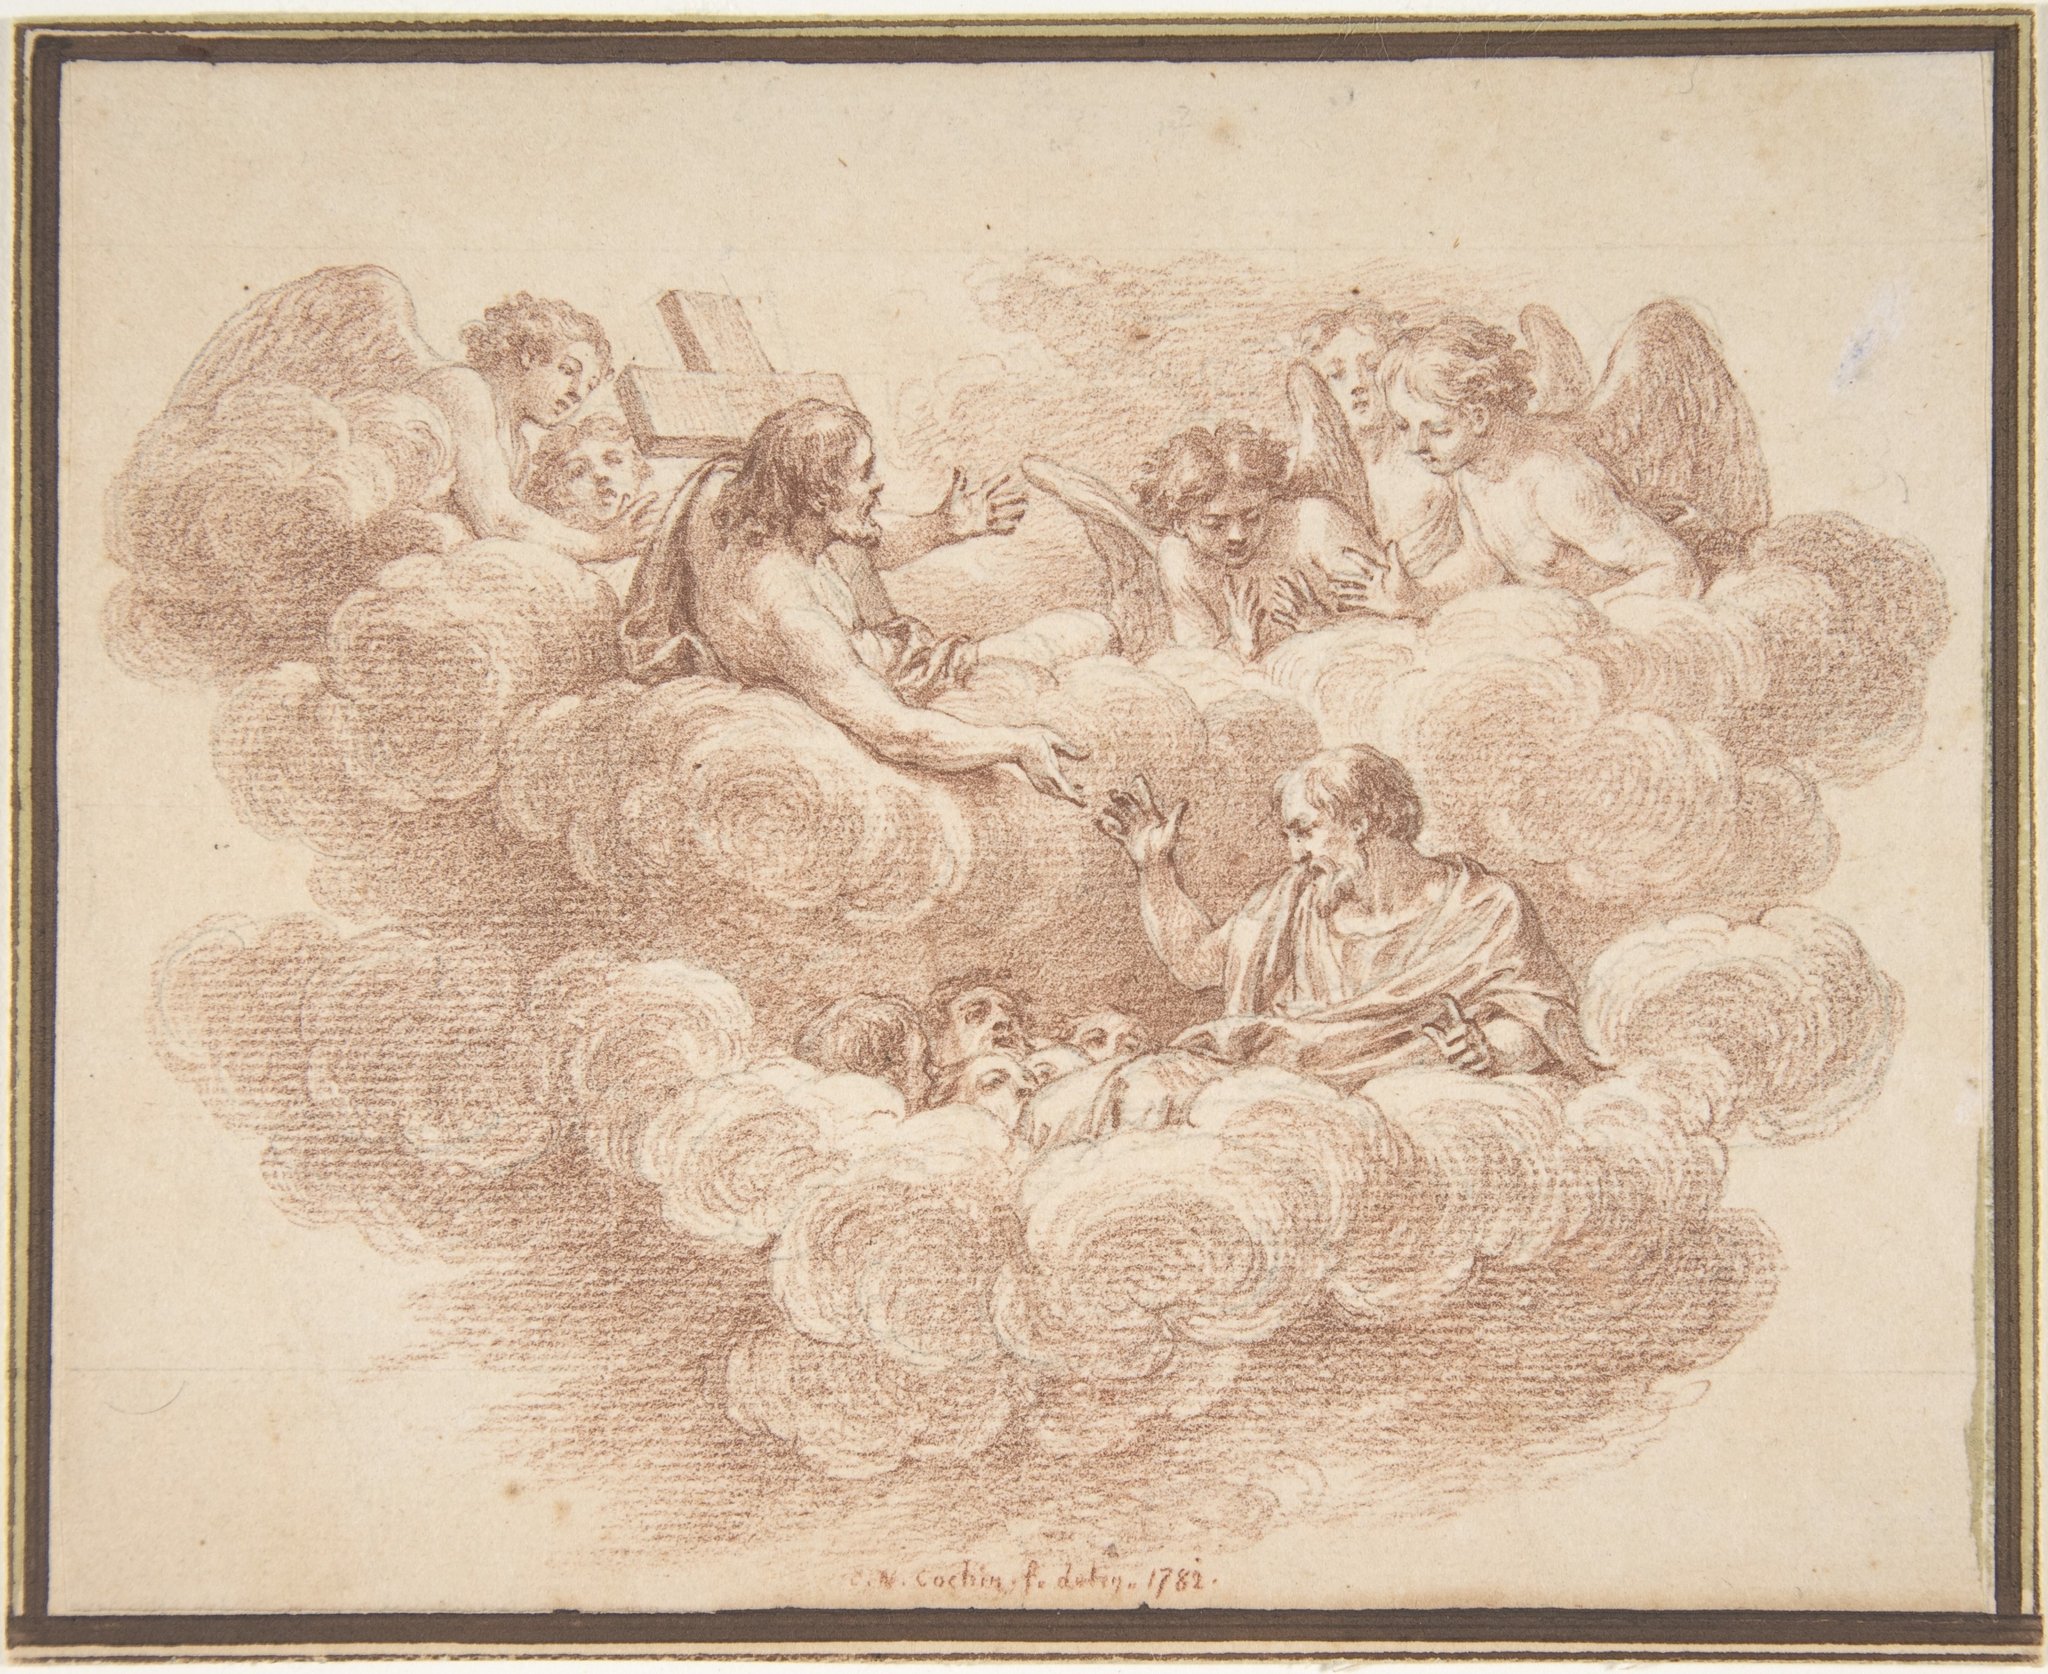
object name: drawing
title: The Risen Christ Appearing to Souls in Purgatory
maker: charles nicolas cochin ii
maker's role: artist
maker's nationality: french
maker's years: 1715-1790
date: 1782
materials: chalk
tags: angels,christ,cross